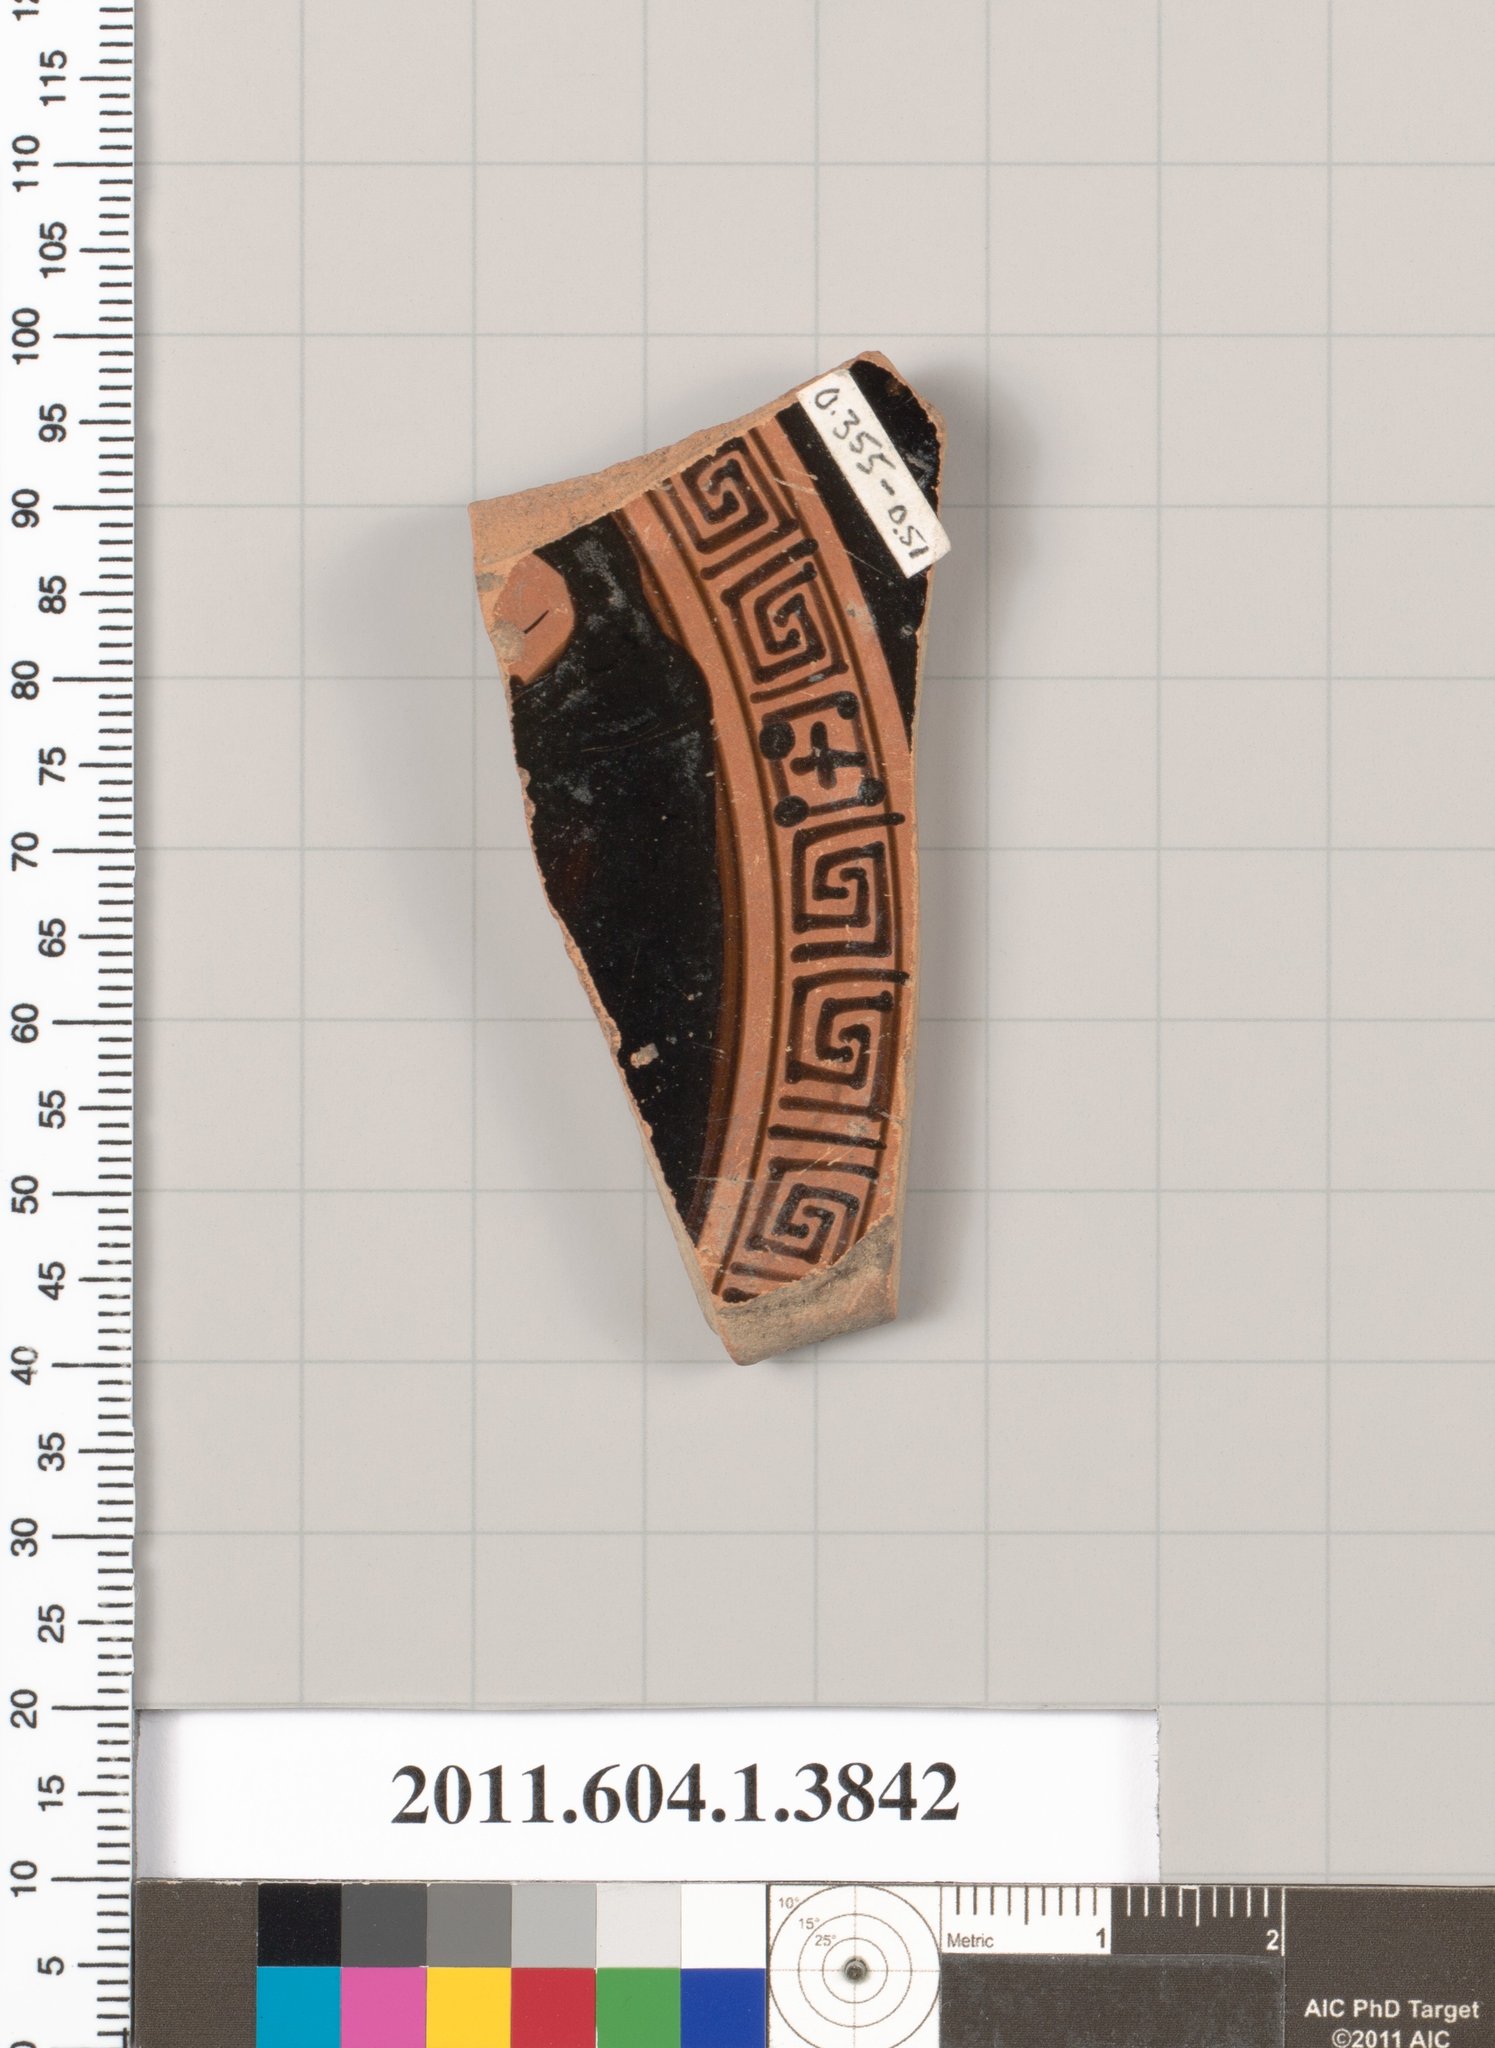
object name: kylix fragment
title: Terracotta fragment of a kylix (drinking cup)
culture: greek, attic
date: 460-440 BCE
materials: terracotta